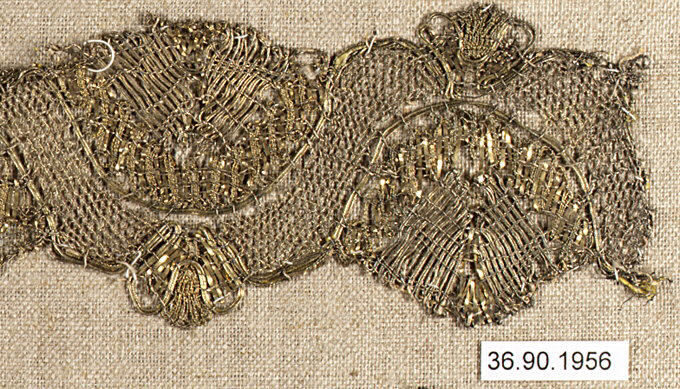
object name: piece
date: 1801-1900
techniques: lace